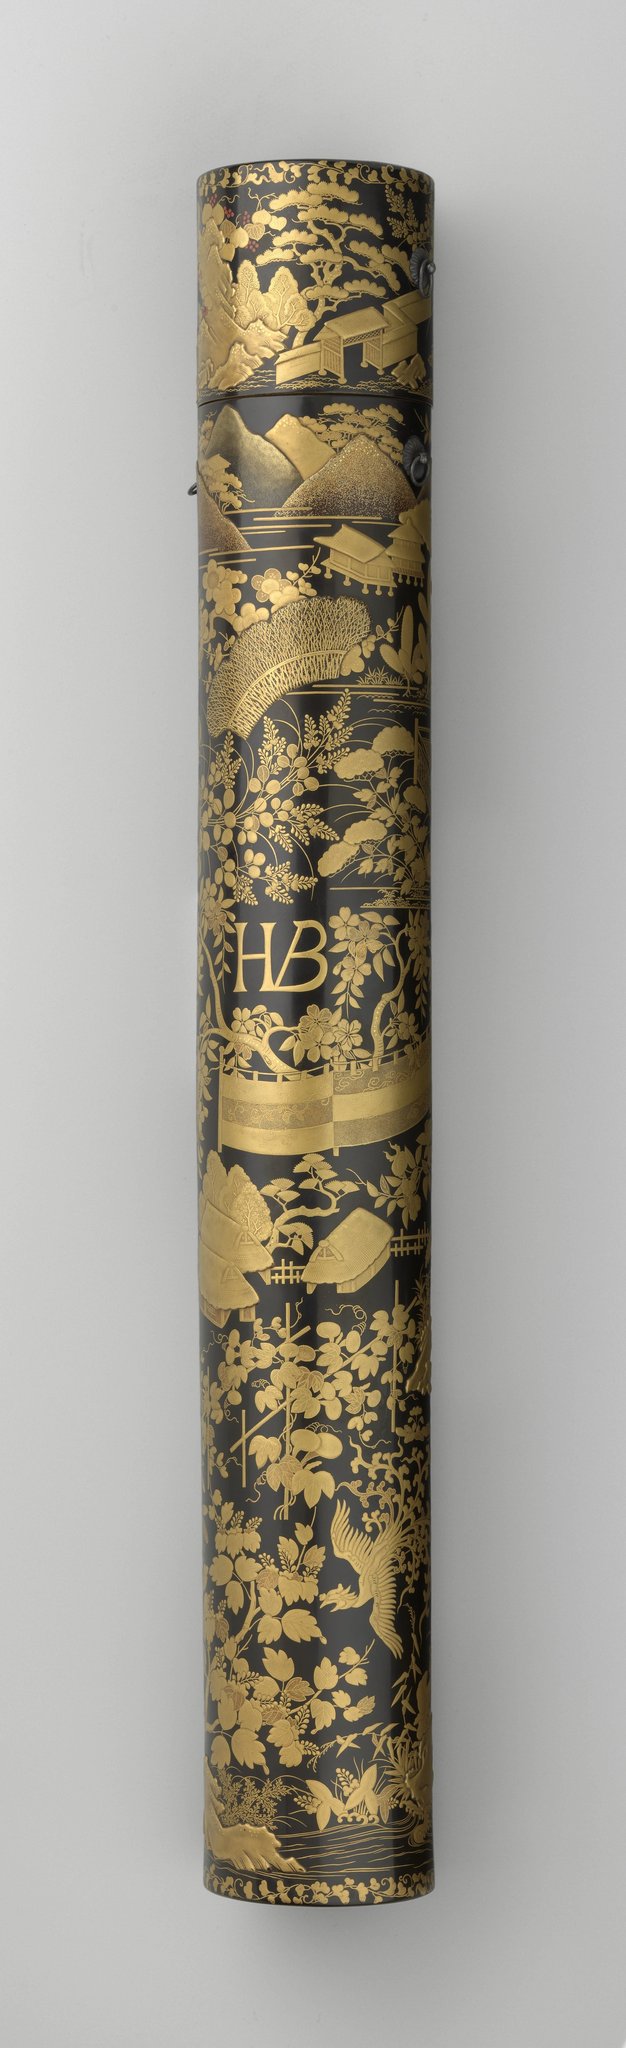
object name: documentkoker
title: Document case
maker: Anonymous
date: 1684-1692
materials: lacquer, wood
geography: japan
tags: verenigde oostindische compagnie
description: This document case is a fine example of the kind of superb lacquerware that was made for the Dutch in 17th-century Japan. The decoration was applied in makie, a technique in which gold powder is sprinkled onto wet lacquer. The initials HVB stand for Hendrick van Buijtenhem (1656–1698). He headed the Dutch East India Company trading post in Japan four times between 1684 and 1692.